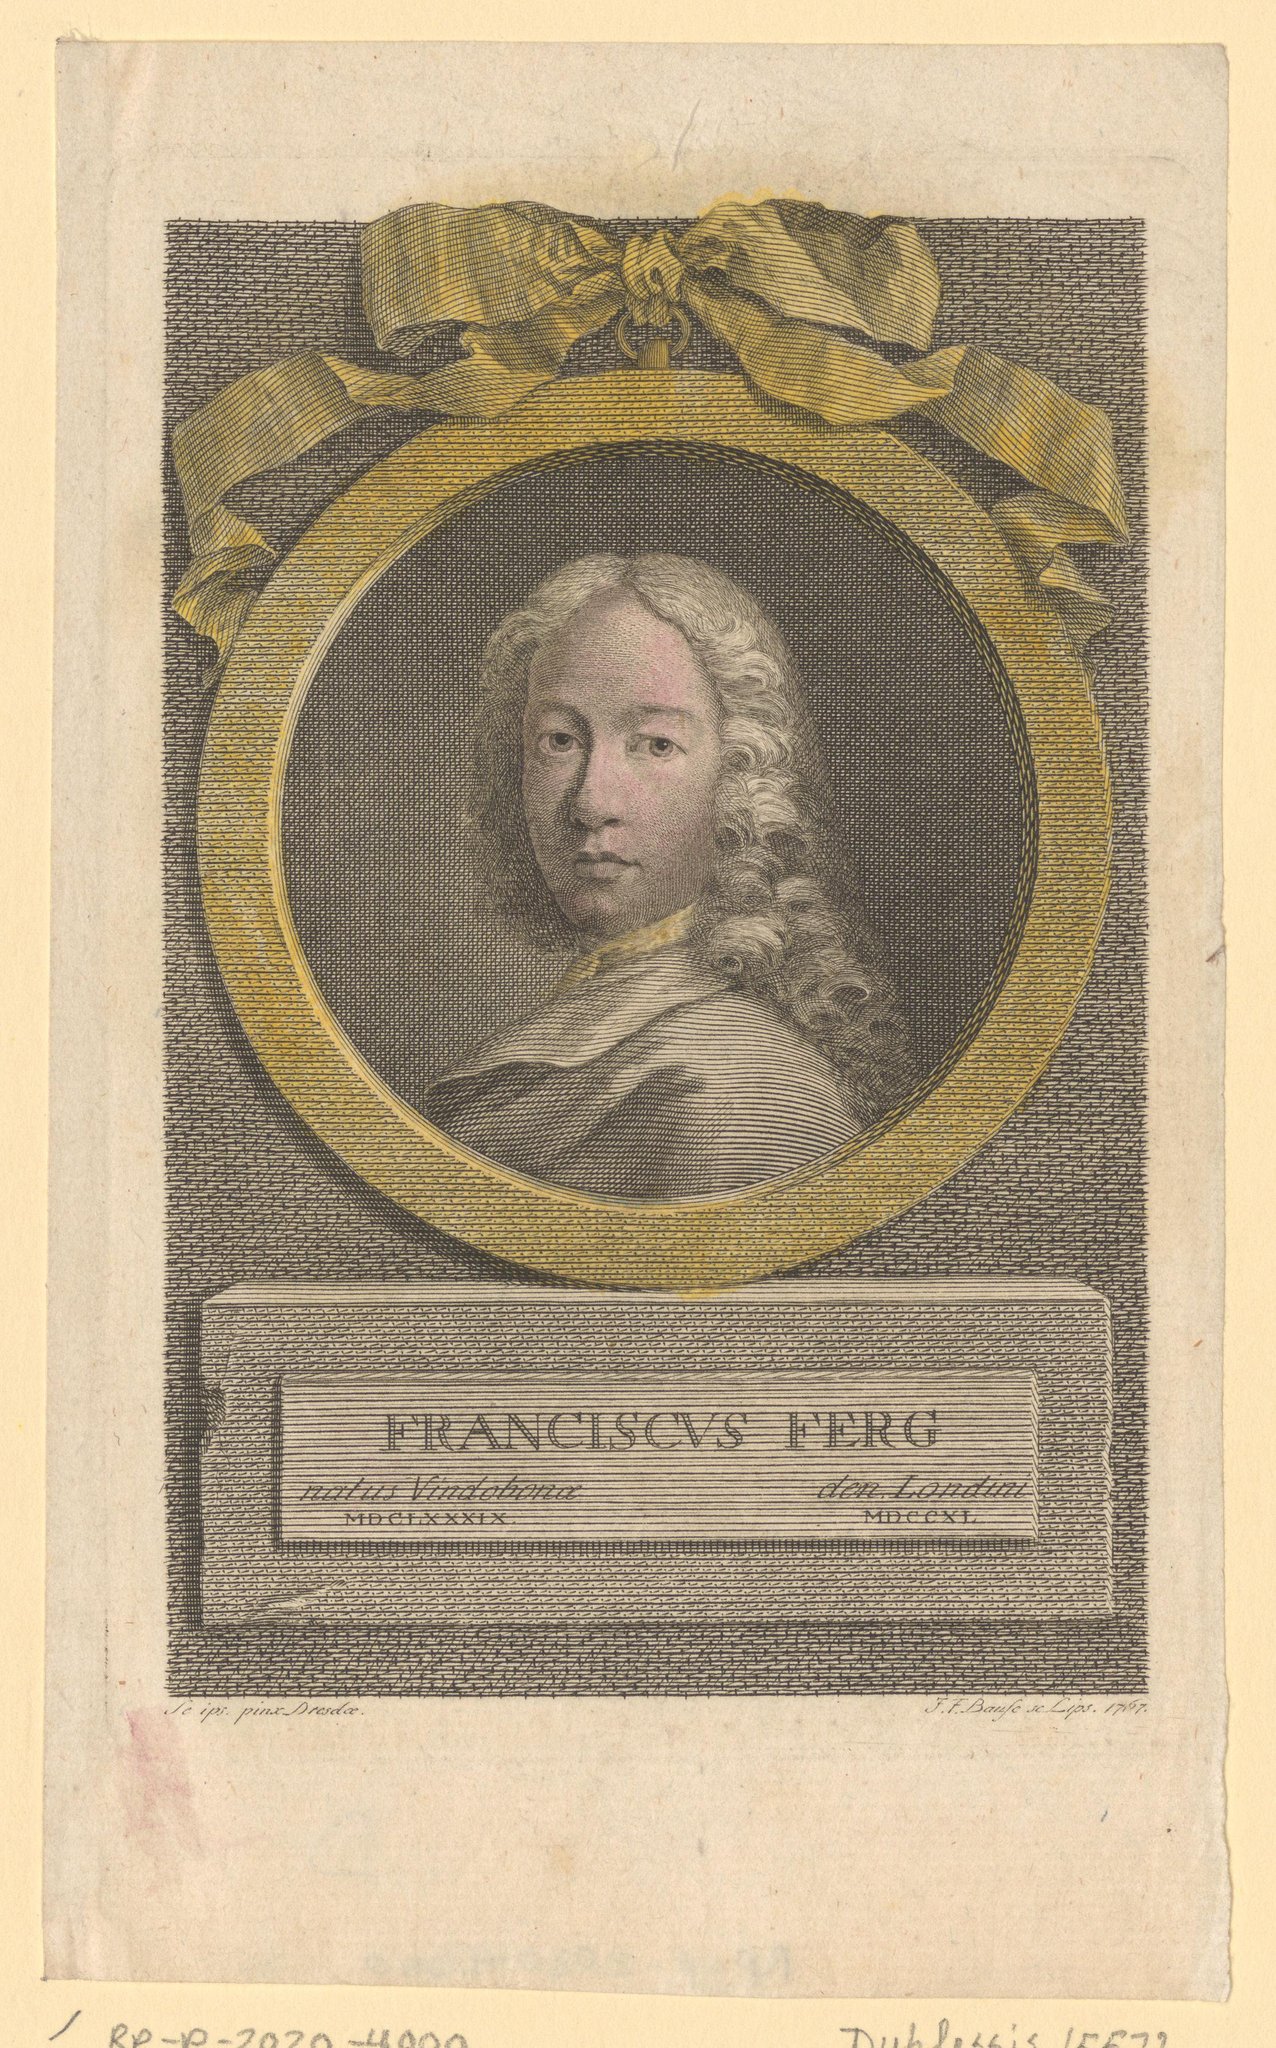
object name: print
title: Portret van Franz de Paula Ferg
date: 1767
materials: paper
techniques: engraving, hand coloring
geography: leipzig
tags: london, painter, print maker, draughtsman, franz de paula ferg, historical persons, portrait, self-portrait of painter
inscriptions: date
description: Volgens Georg Keil is deze prent ook gebruikt in een editie van Neue Bibliothek der schönen Wissenschaften.